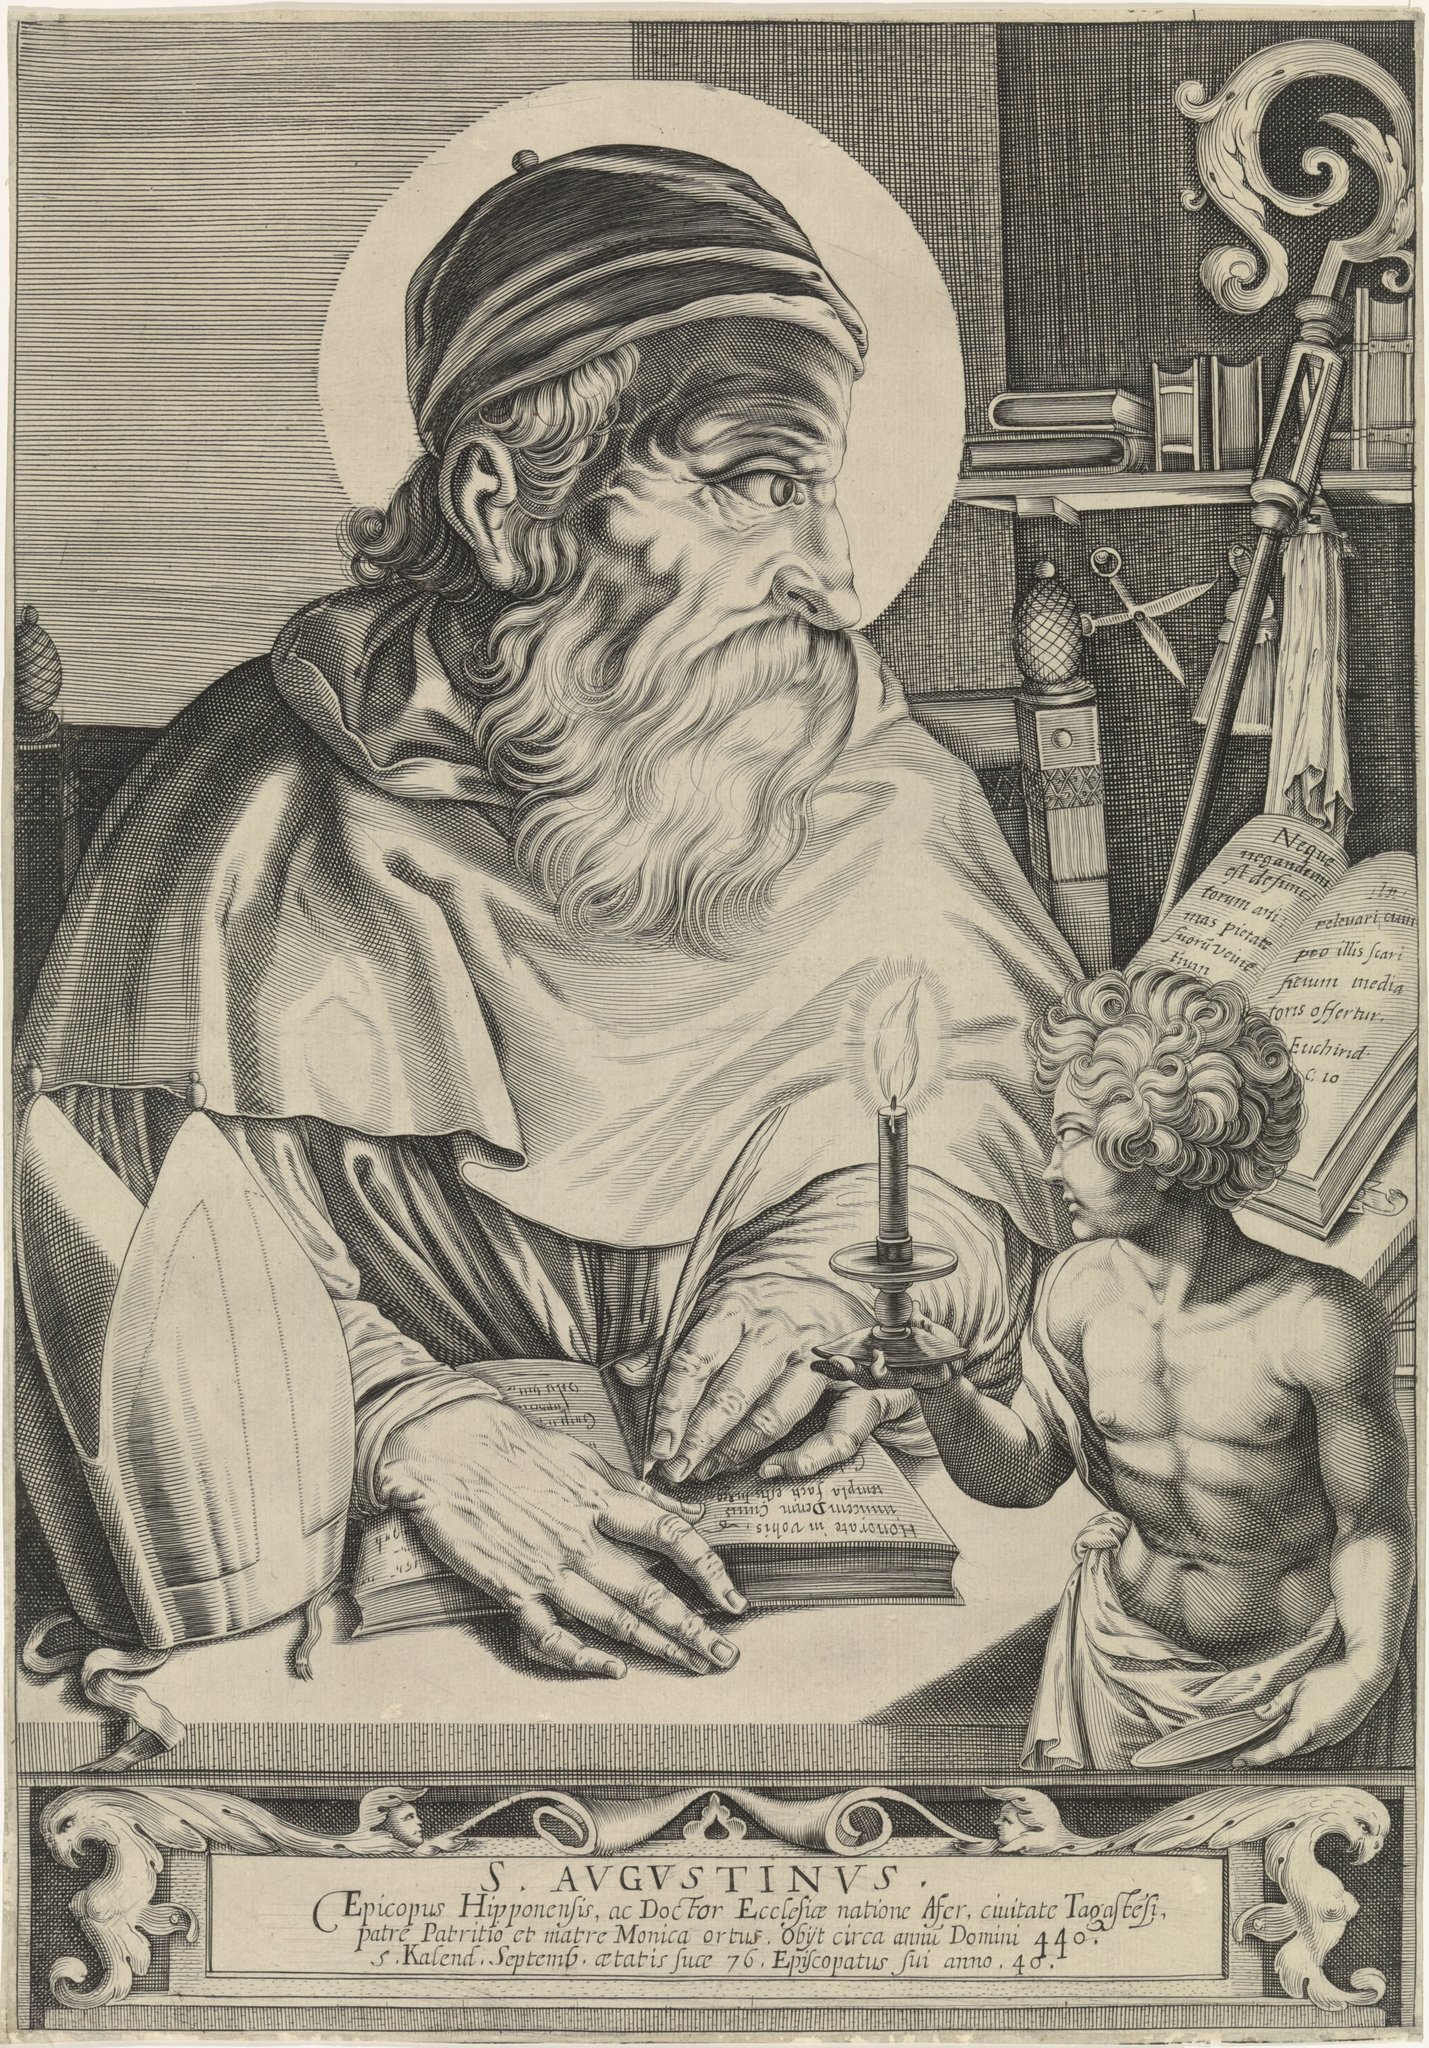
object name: print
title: Kerkvader Augustinus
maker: egbert van panderen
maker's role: print maker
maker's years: 1580-1637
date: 1590-1637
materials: paper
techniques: engraving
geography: antwerp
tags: candle (+ giving someone a light), st. augustine as doctor of the latin church in his study, at his writing-desk, with book, pen and sometimes a dove (divine inspiration)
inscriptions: collector's mark: Lugt 2228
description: De H. Augustinus, bisschop van Hippo, schrijvend in een boek in zijn werkkamer. Zijn bisschopsmijter ligt naast hem en zijn staf staat tegen een plank aan. Een naakte figuur houdt een kandelaar met een brandende kaars vast. In een kader zijn naam en een drieregelig onderschrift in het Latijn. Prent uit een serie van vier met de kerkvaders.